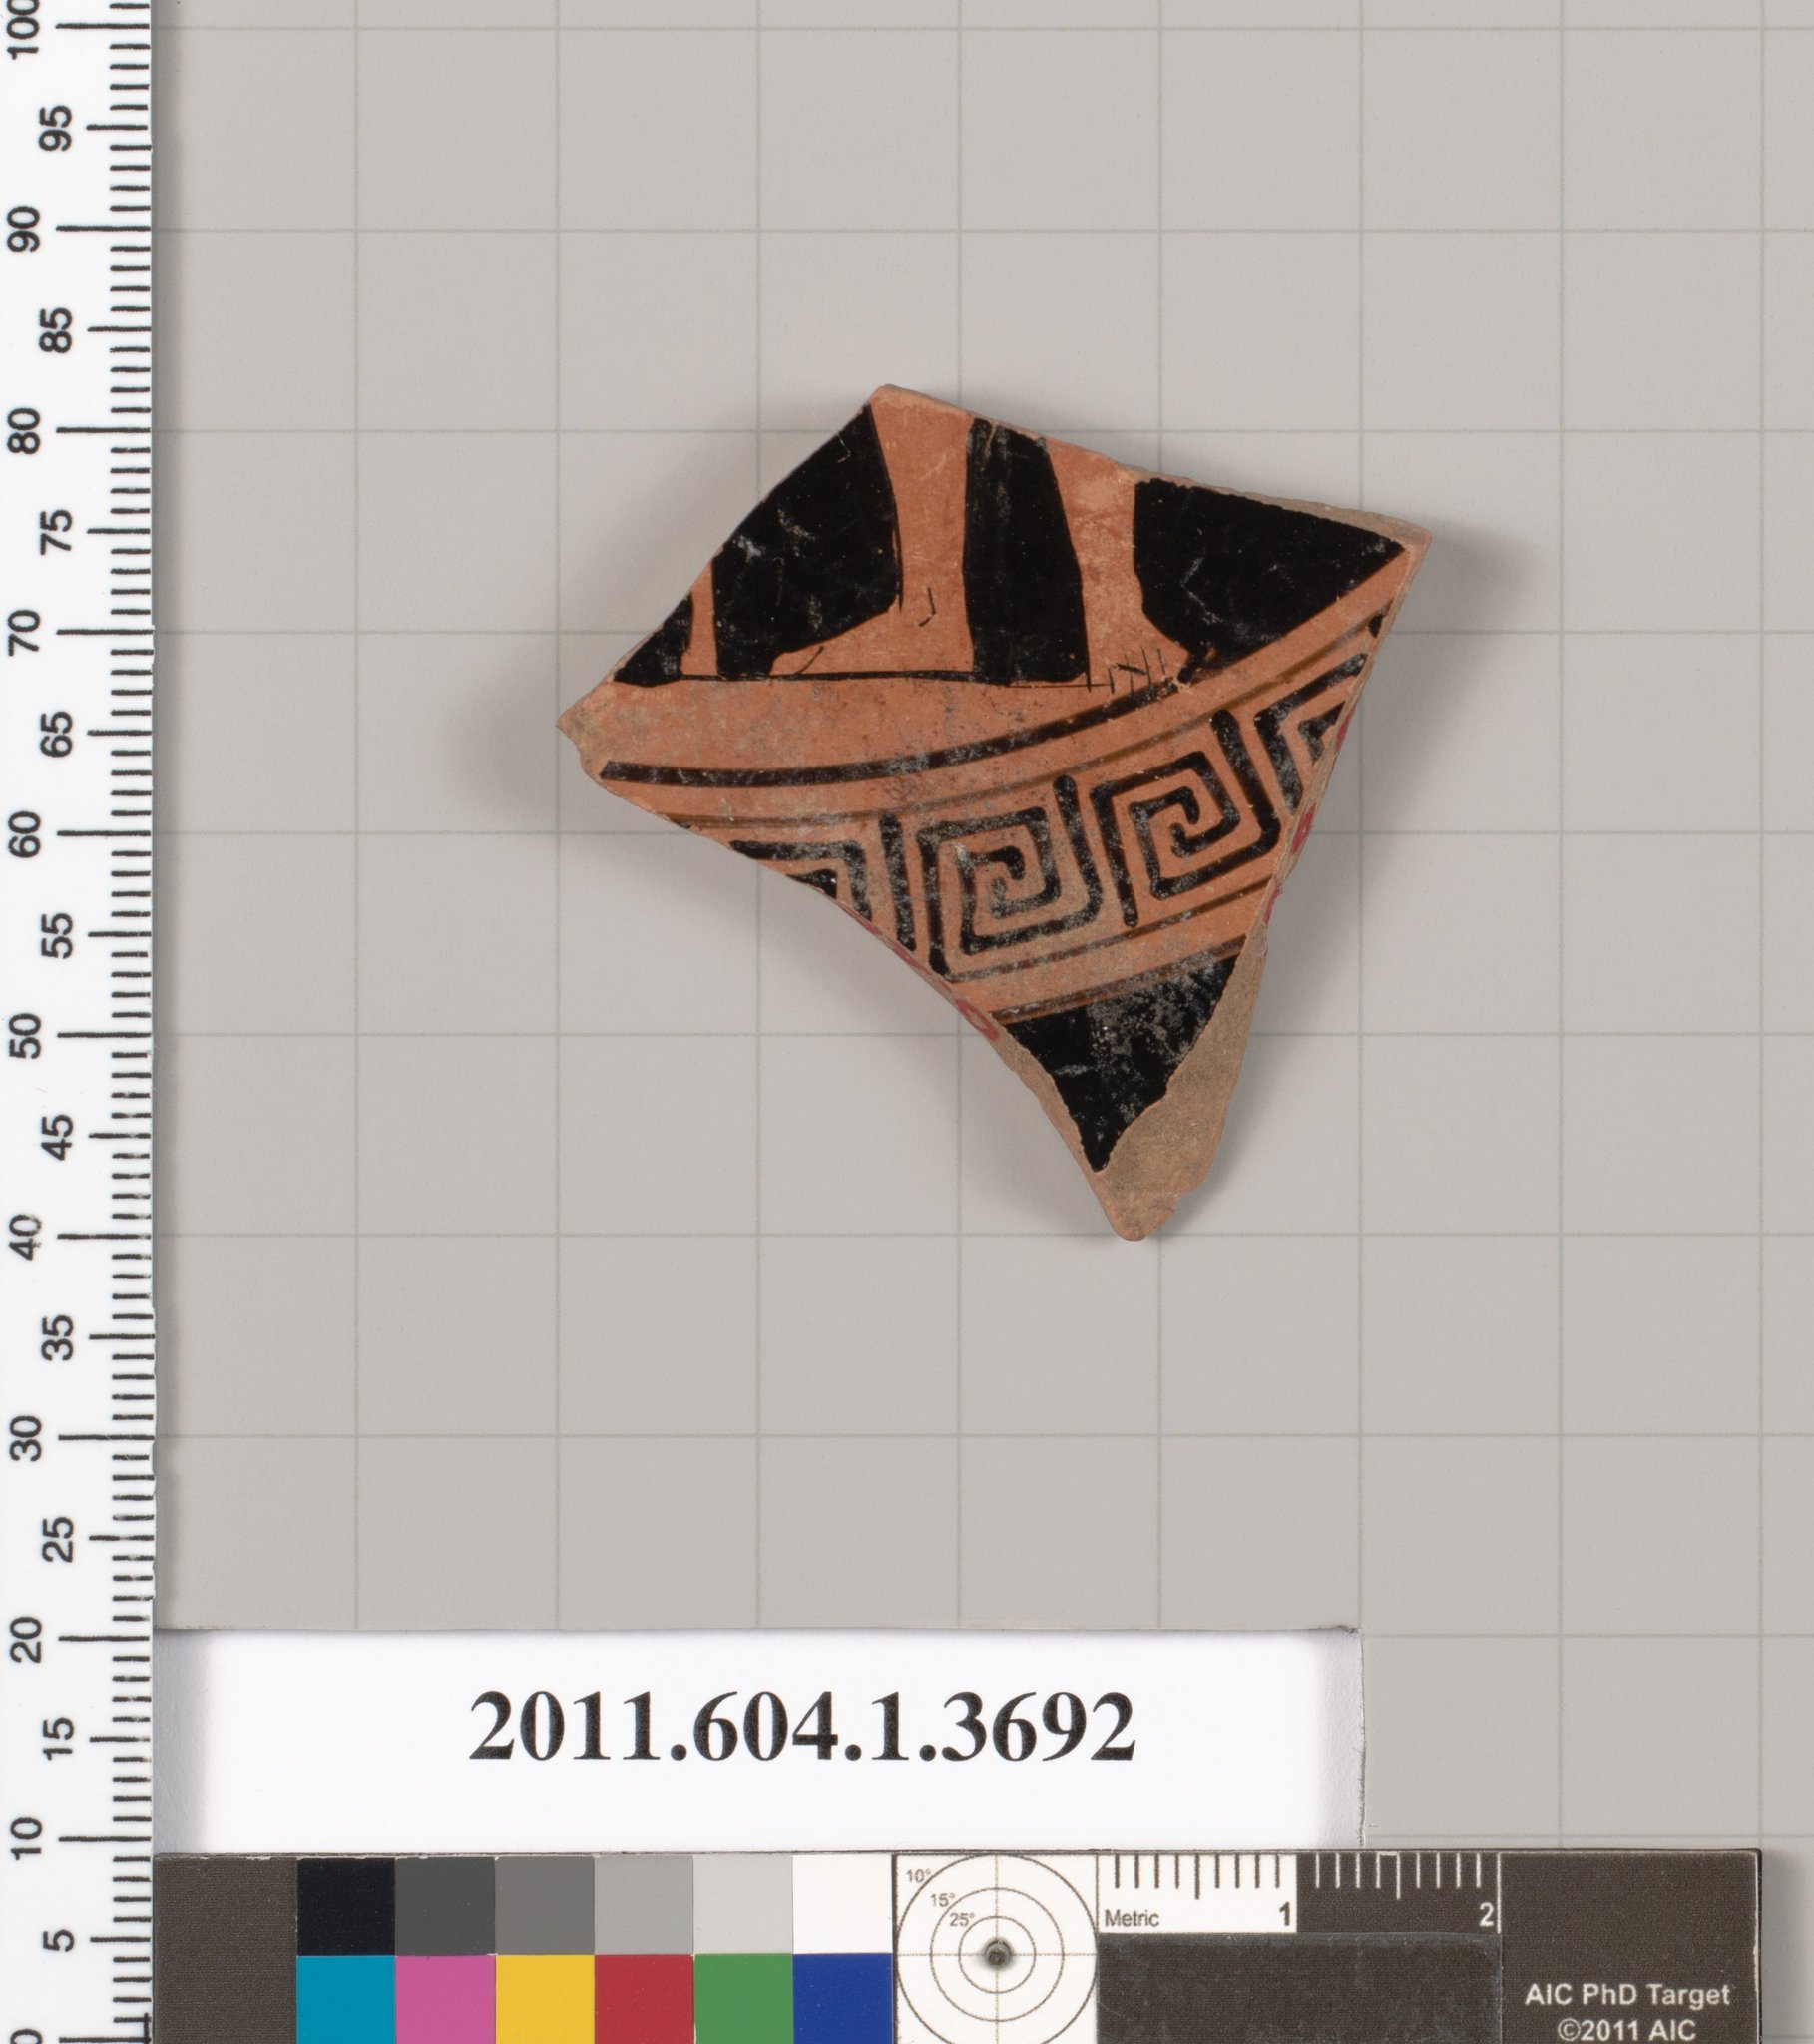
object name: kylix fragment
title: Terracotta fragment of a kylix (drinking cup)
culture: greek, attic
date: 475-451 BCE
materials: terracotta